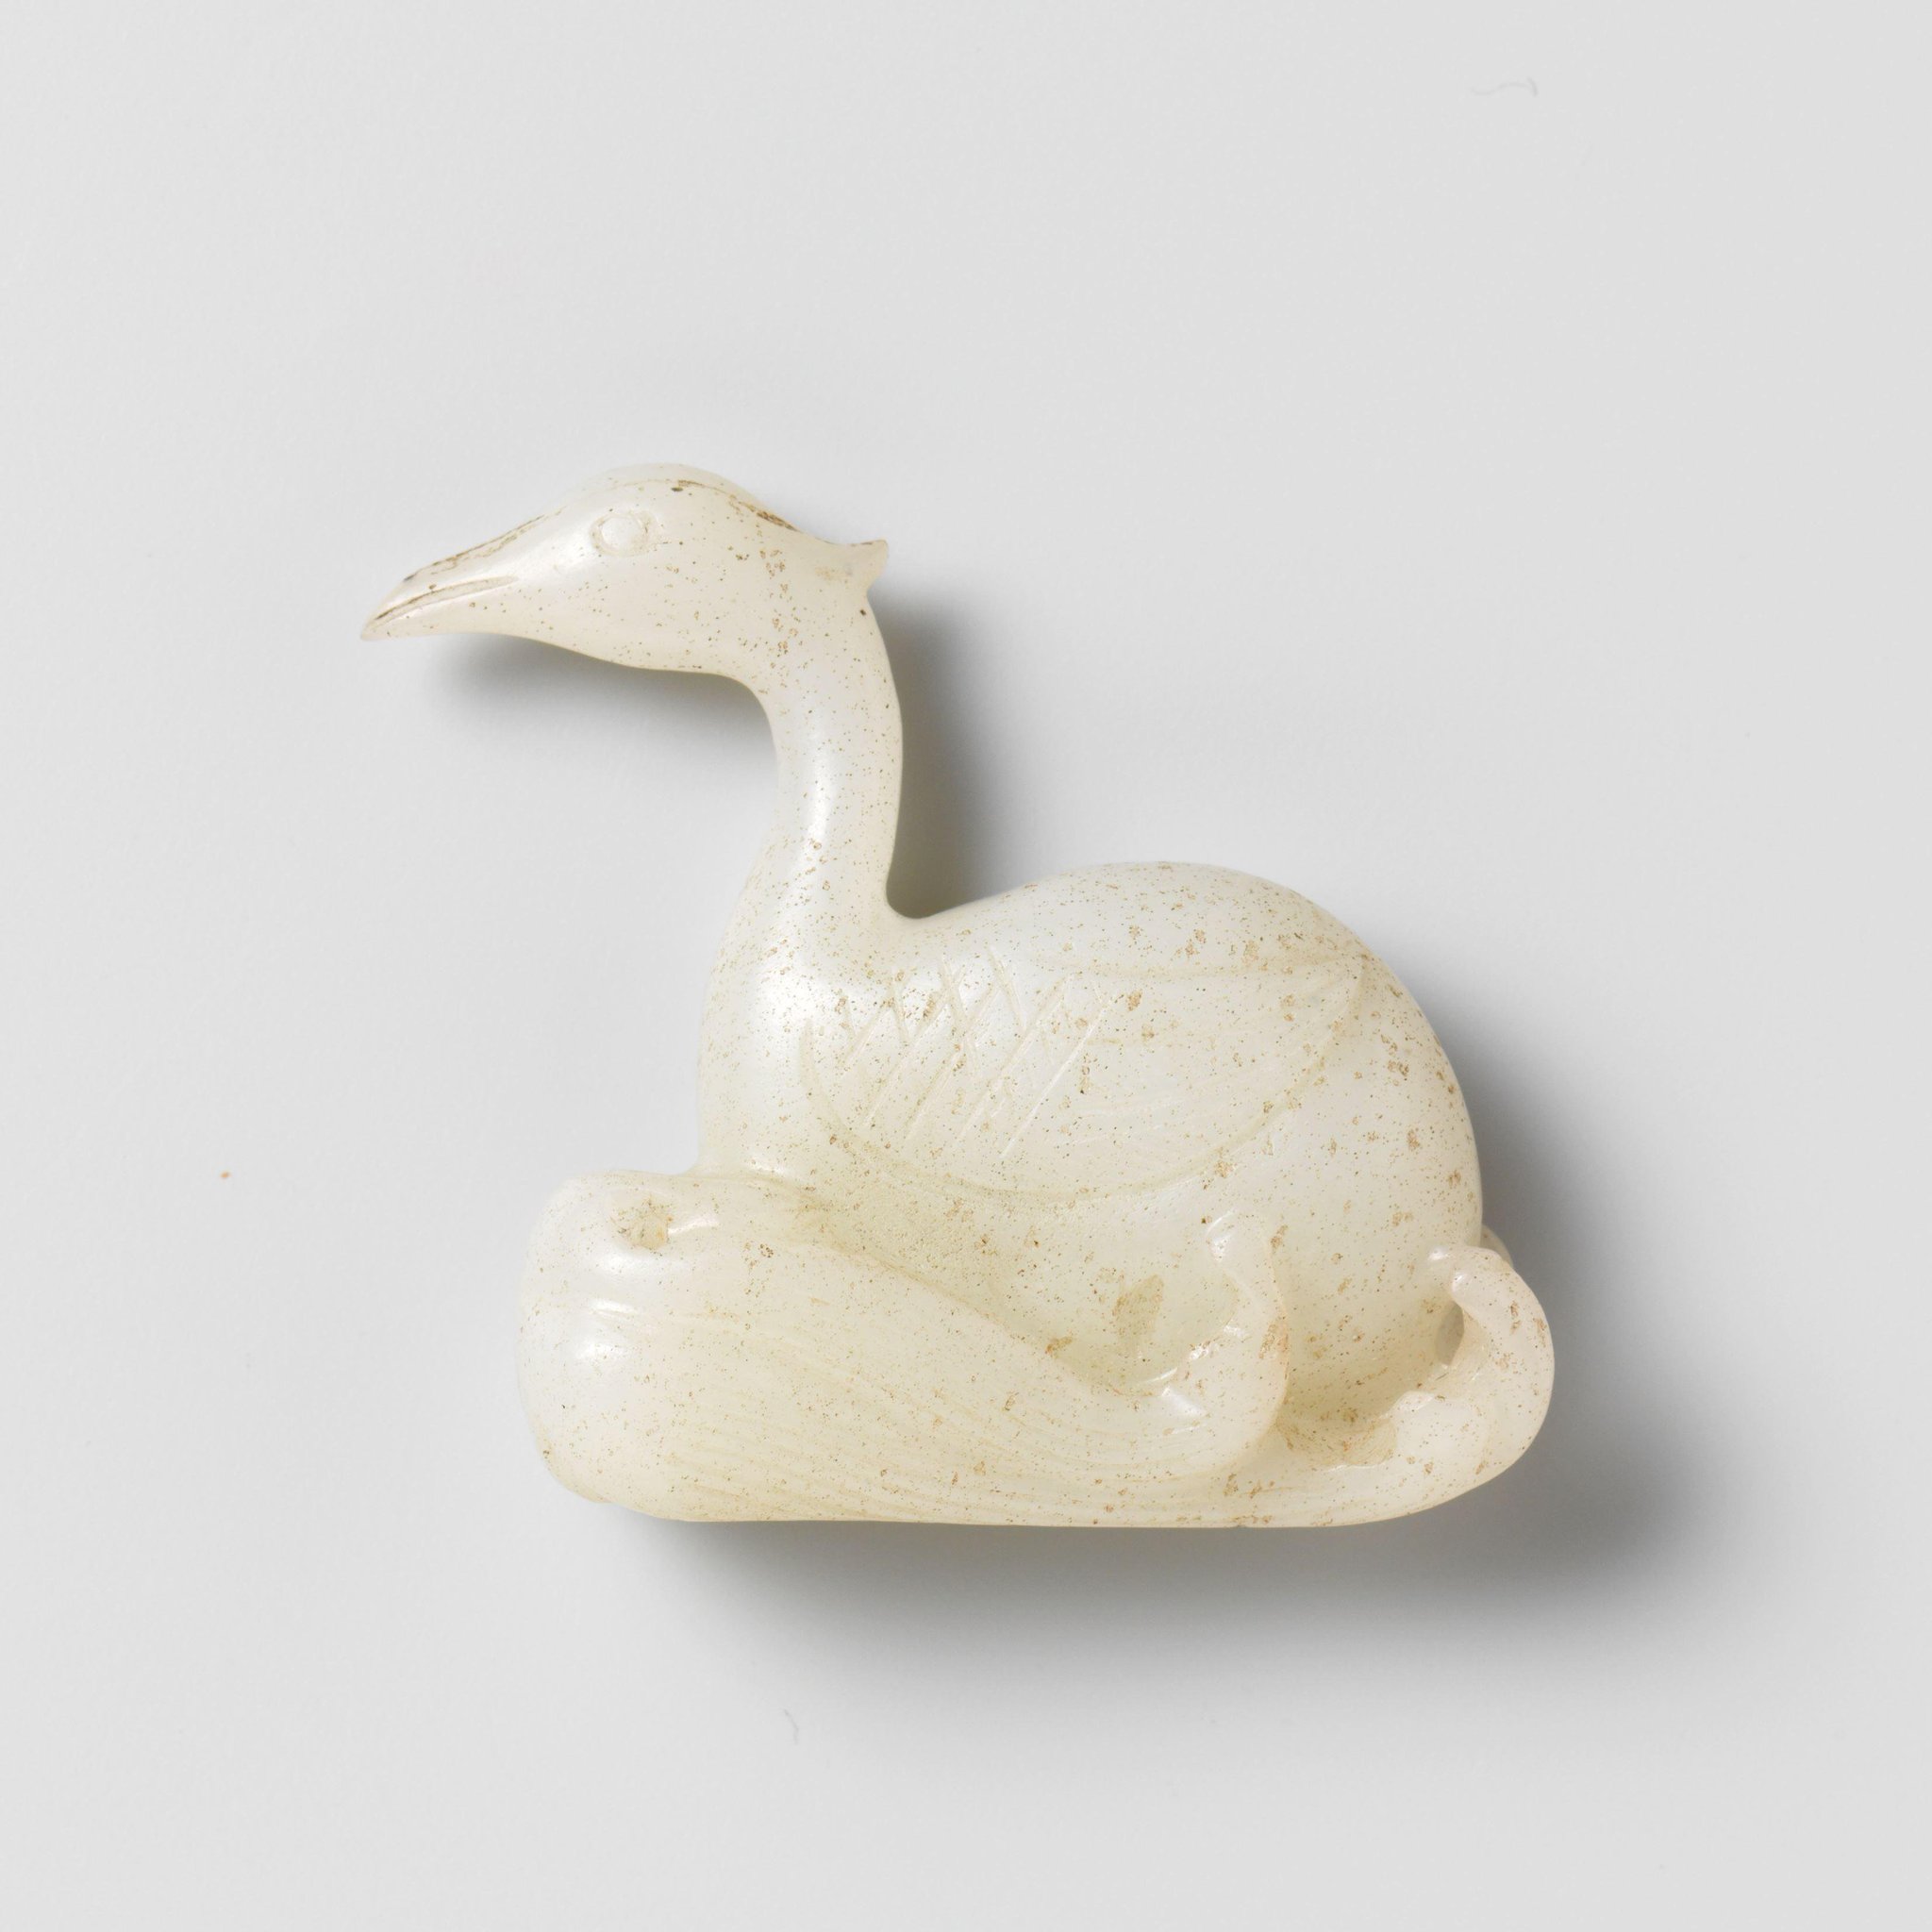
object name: gordelpendant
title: Bird ornament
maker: Anonymous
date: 907-1125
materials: wood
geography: china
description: Voet van gordelpendant in de vorm van een fuut.